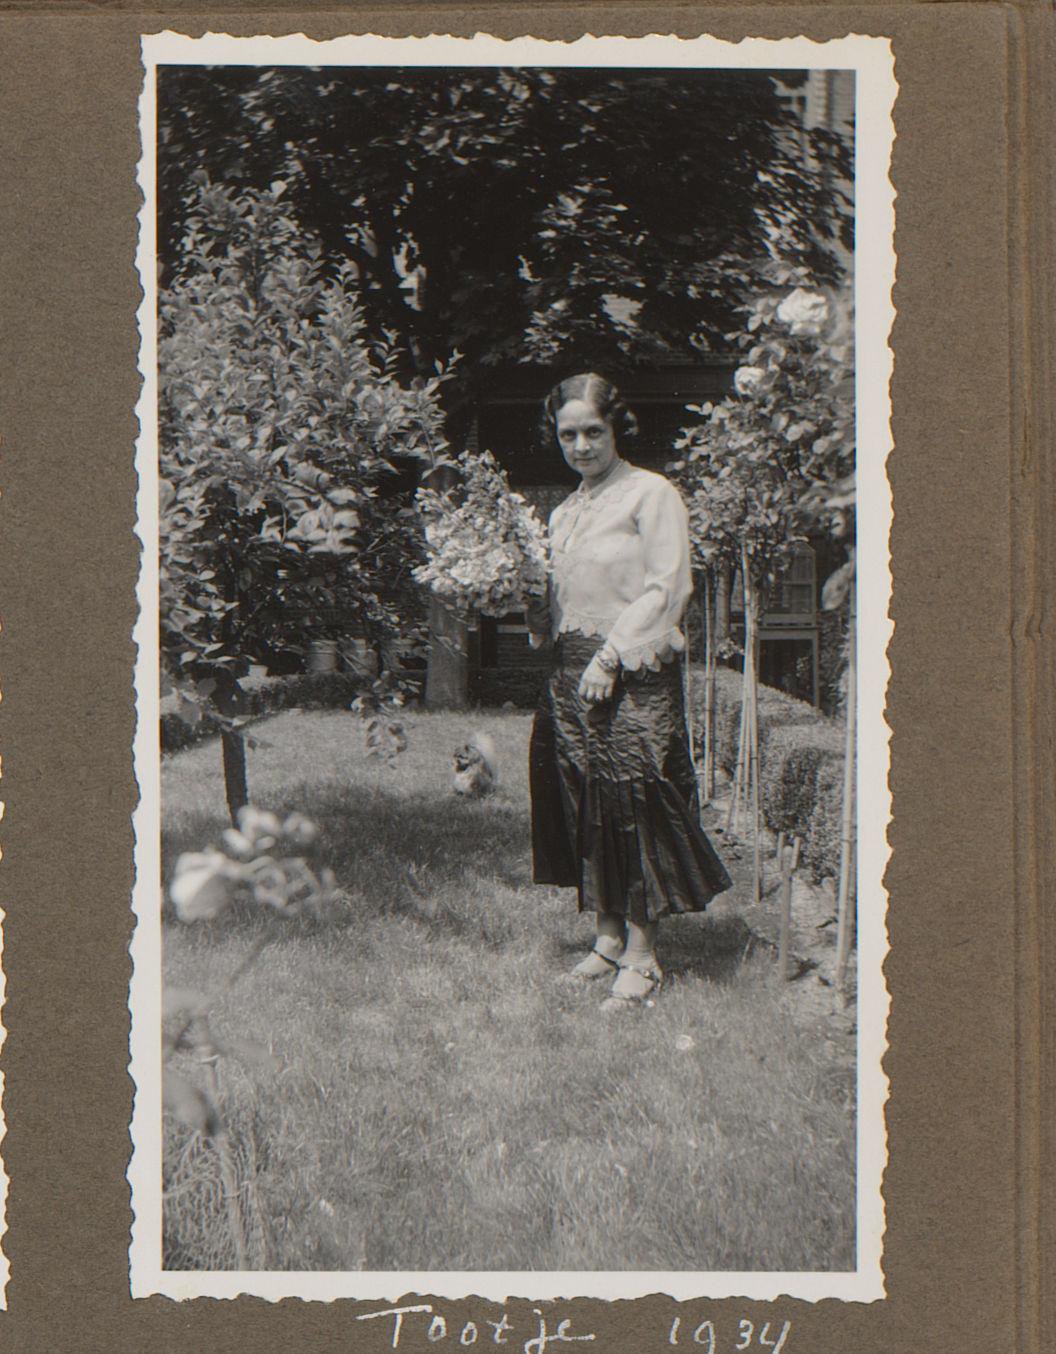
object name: photograph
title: Portret van Tootje Wassink in een tuin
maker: Anonymous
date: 1934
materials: paper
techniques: gelatin silver print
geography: netherlands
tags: historical persons not known by name - bb - woman, netherlands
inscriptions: inscription: ‘Tootje 1934’